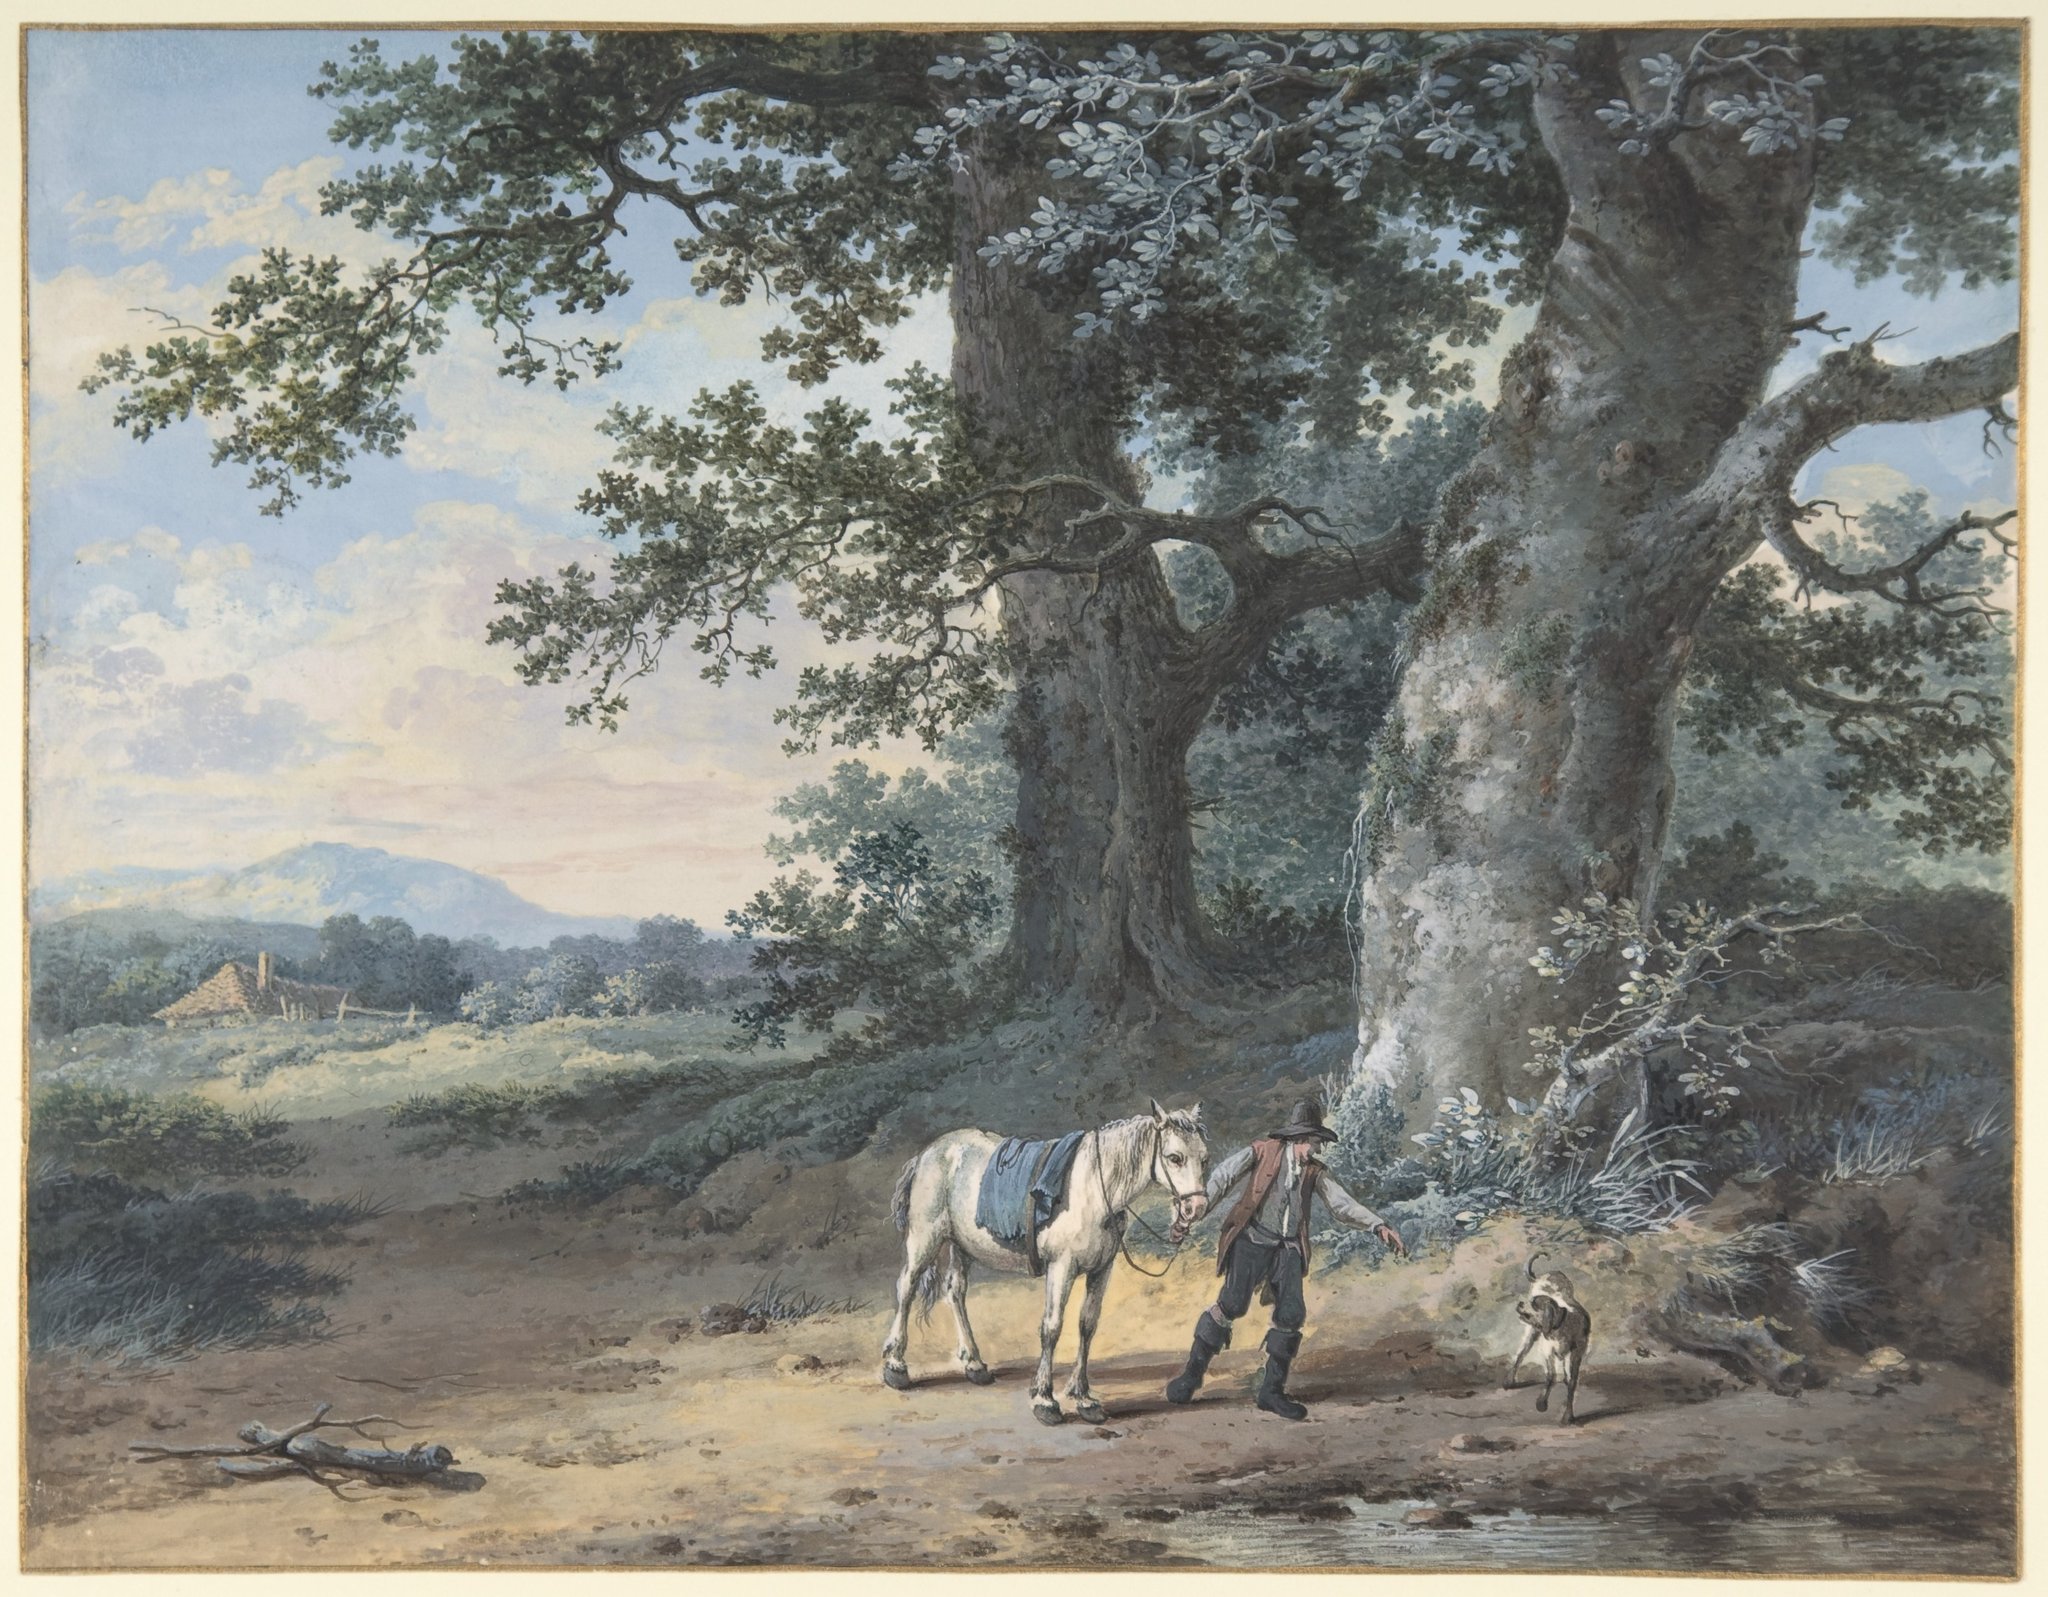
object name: drawing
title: A Peasant Leading his Horse on the Outskirts of a Wood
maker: pieter barbiers ii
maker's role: artist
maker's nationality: dutch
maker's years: 1749-1842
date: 1761-1842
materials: gold, gouache, graphite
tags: men,dogs,horses,trees